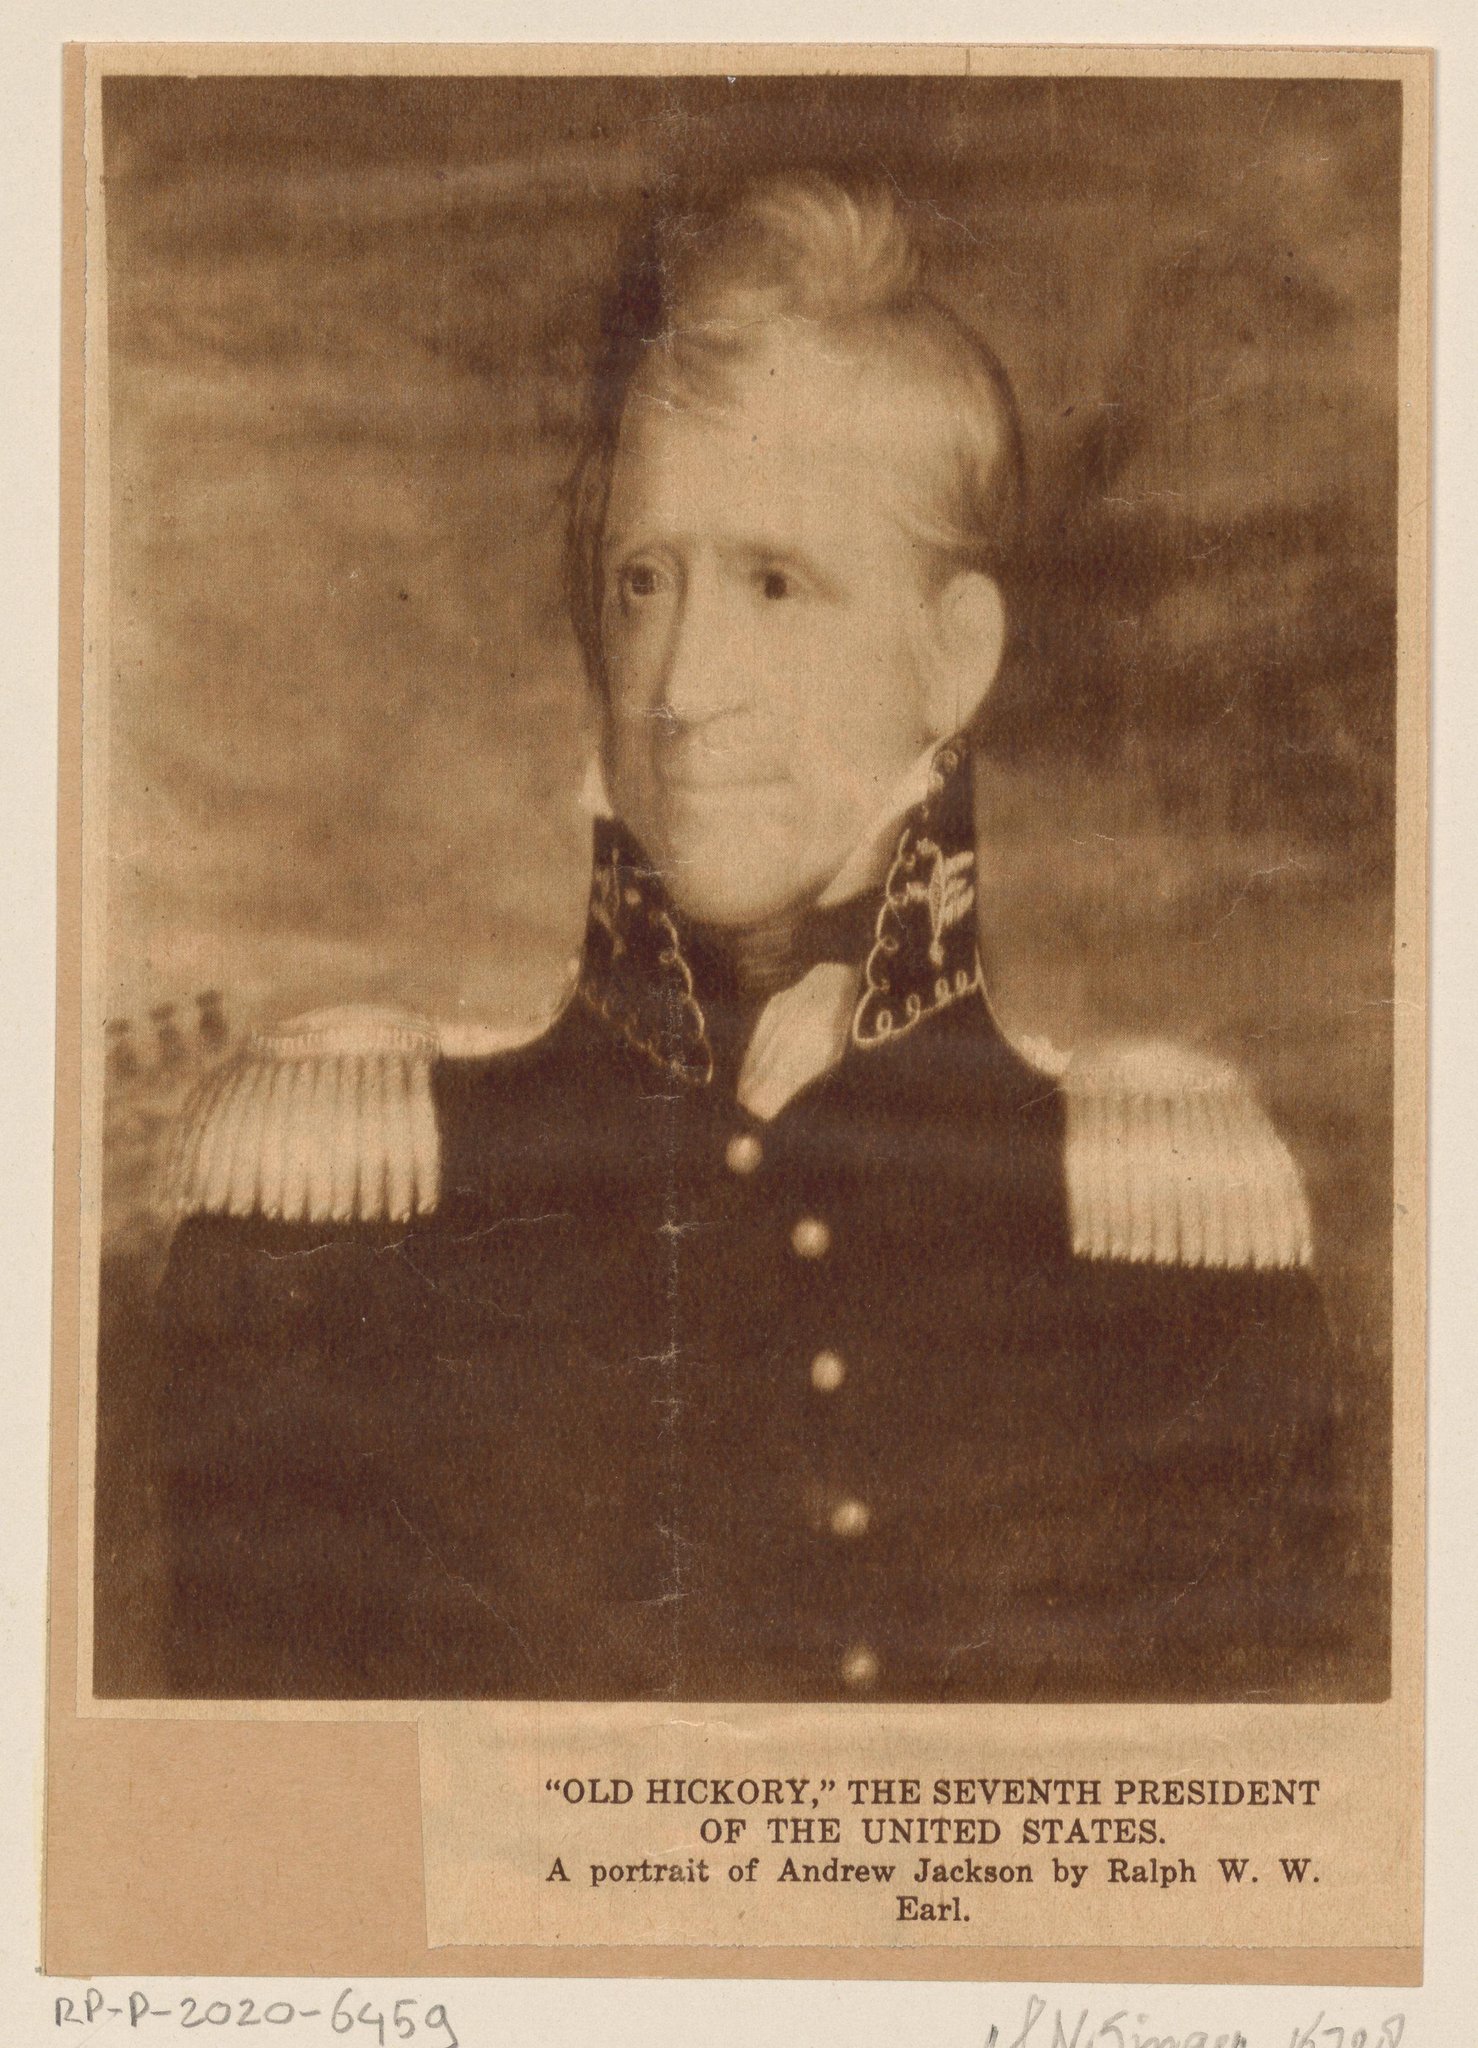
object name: photomechanical print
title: Portret van Andrew Jackson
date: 1881-1920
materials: paper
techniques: rotogravure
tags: president ~ head of republic, historical persons